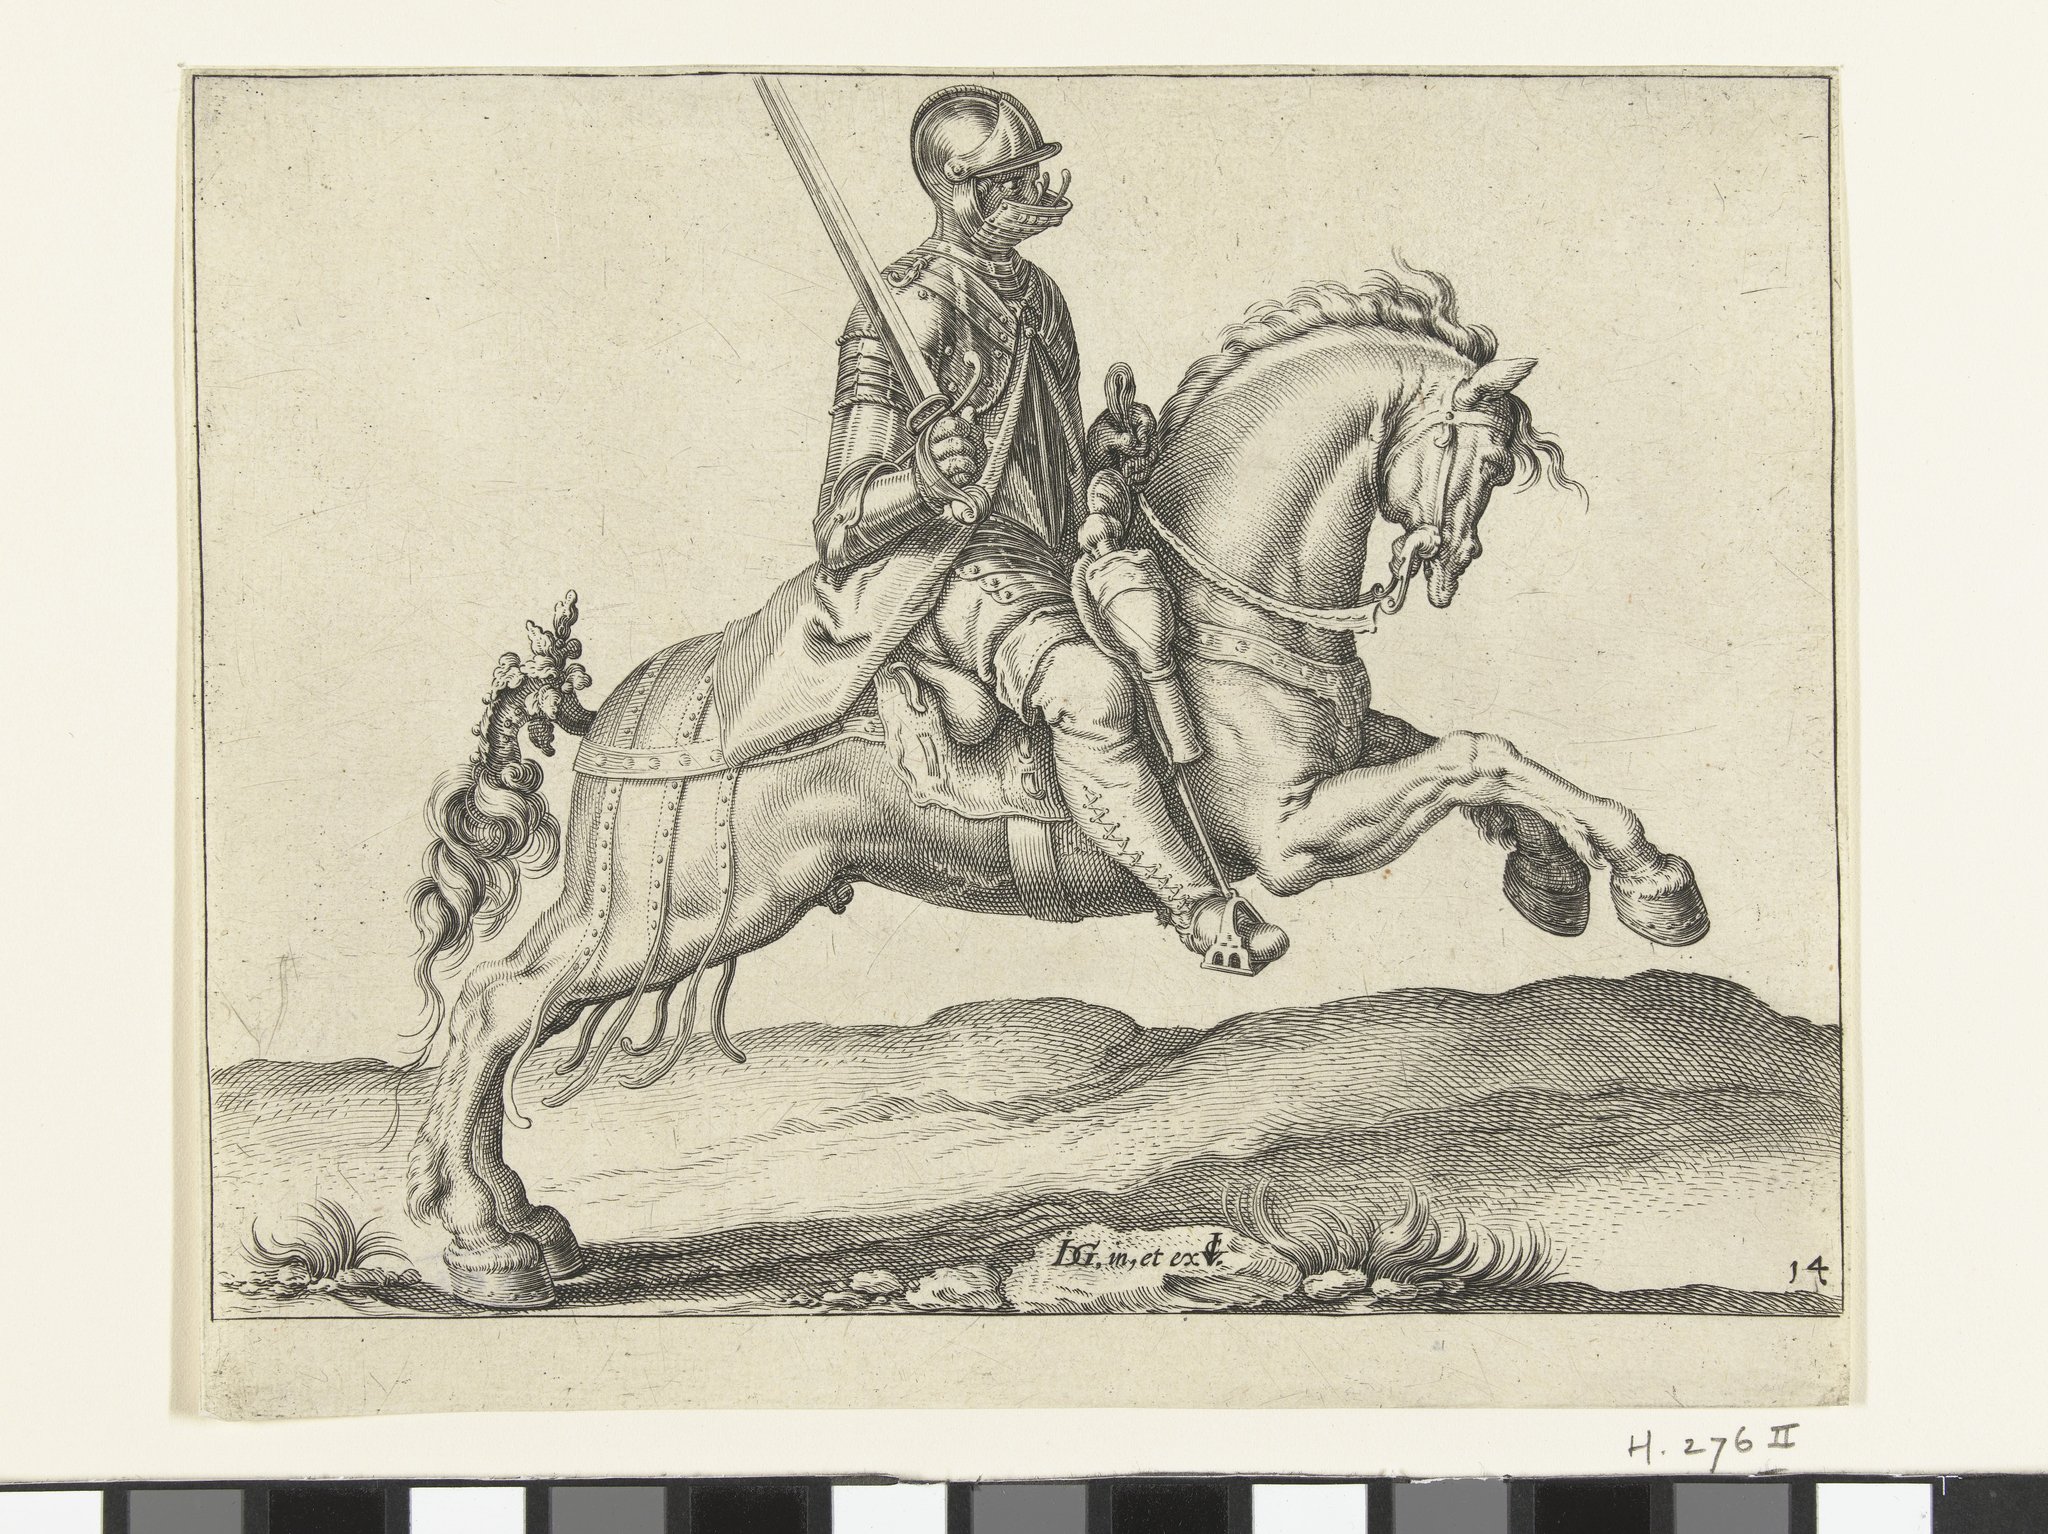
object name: print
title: Ruiter met getrokken zwaard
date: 1599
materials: paper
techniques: engraving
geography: leiden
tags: hacking and thrusting weapons: sword, warfare; military affairs (+ cavalry, horsemen)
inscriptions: collector's mark: Lugt 2228a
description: Een geharnaste man te paard met getrokken zwaard, naar rechts rijdend. Deze prent is onderdeel van een serie van 22 genummerde prenten: een titelprent, 20 prenten waarop één of enkele verschillende typen (meest geharnaste) ruiters zijn weergegeven, en een prent met een ruitergevecht.